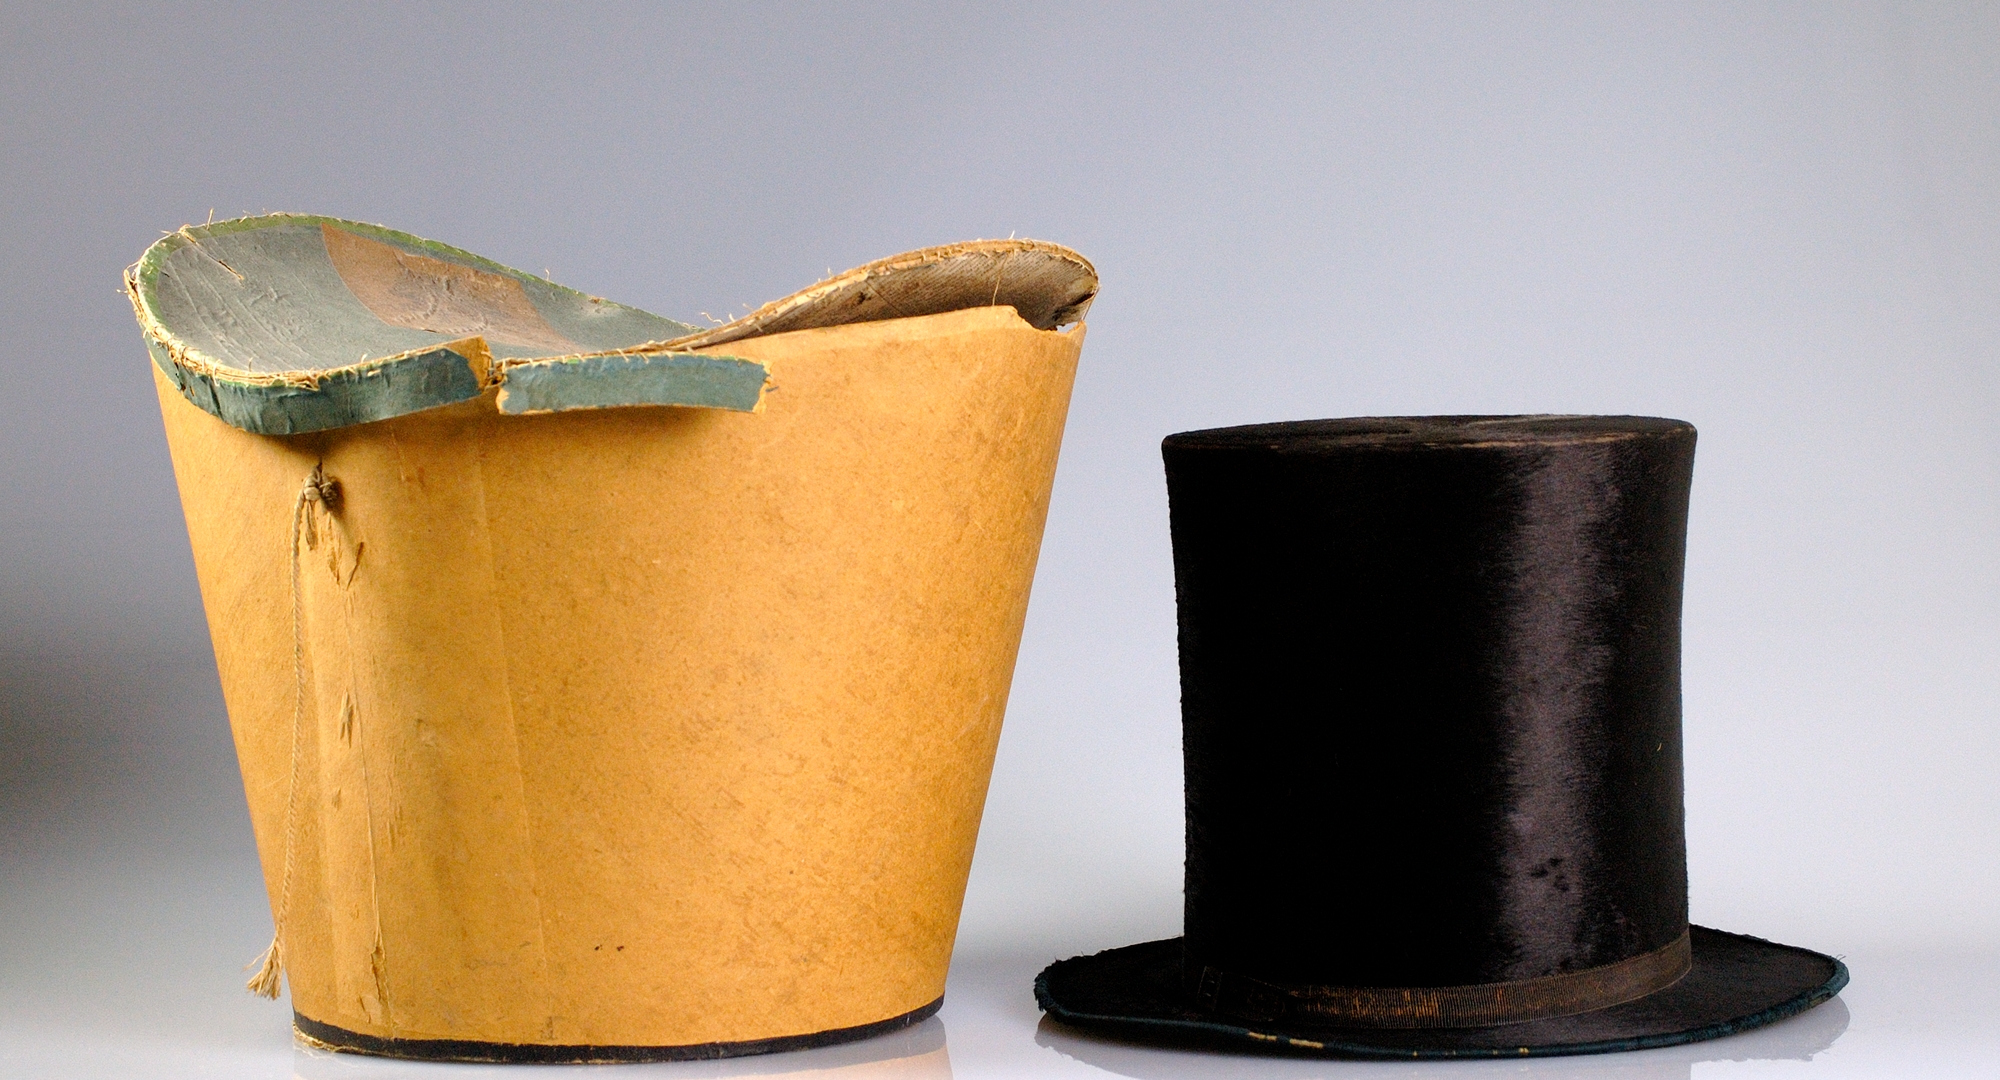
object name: top hat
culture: american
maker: crofut & thomas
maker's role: maker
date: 1851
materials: fur, paper, silk